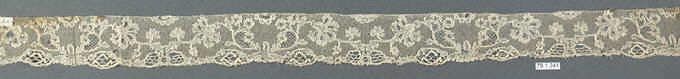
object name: strip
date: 1701-1800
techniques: lace